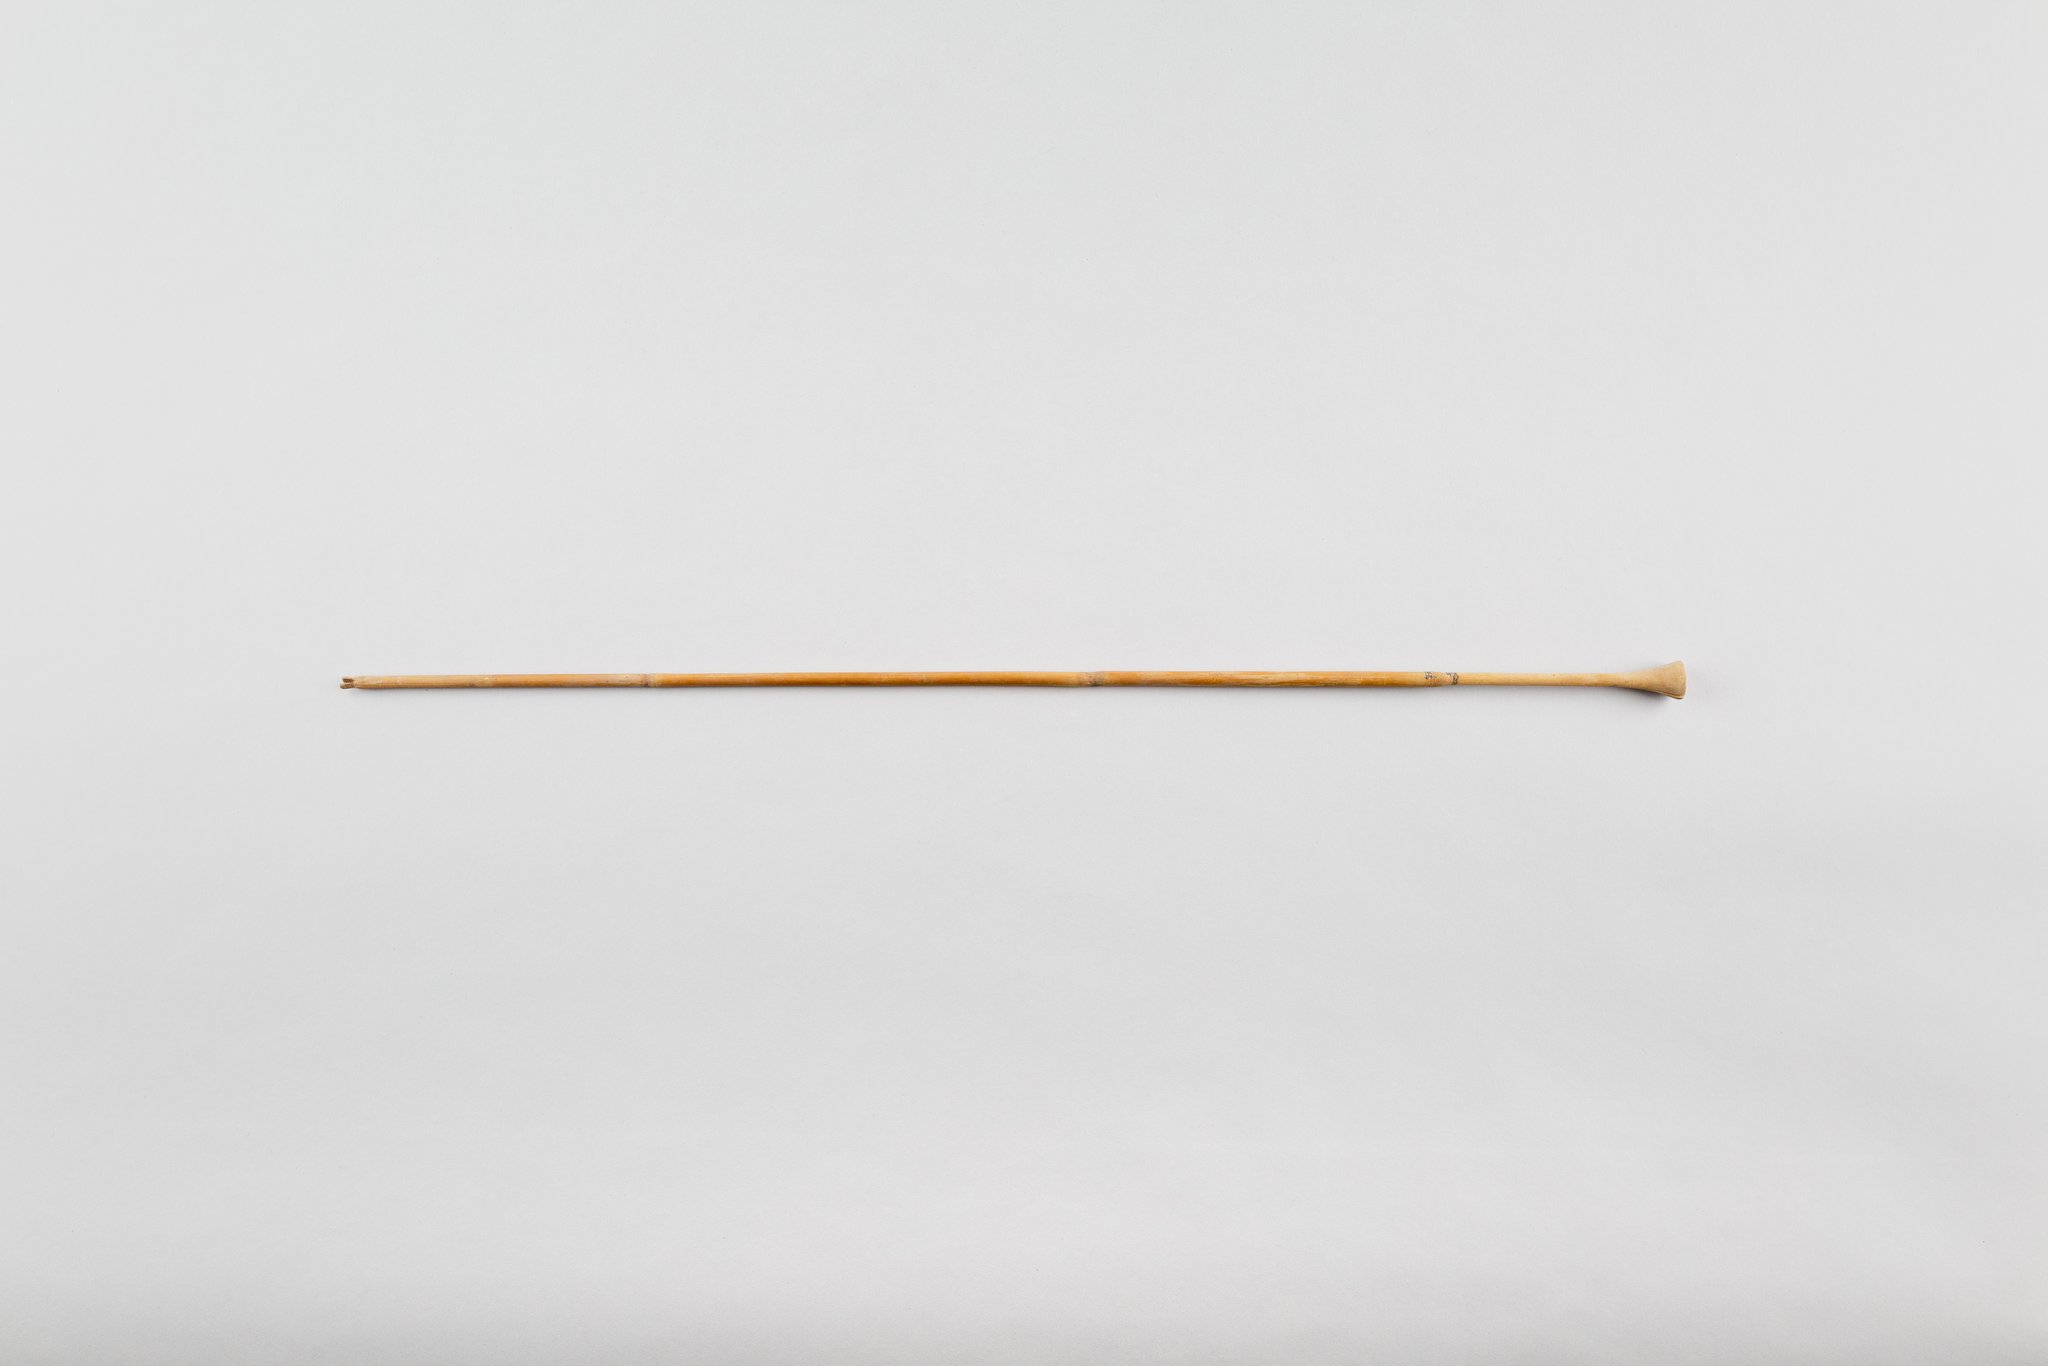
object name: arrow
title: Blunt Tipped Arrow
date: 1479-1458 BCE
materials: wood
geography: egypt